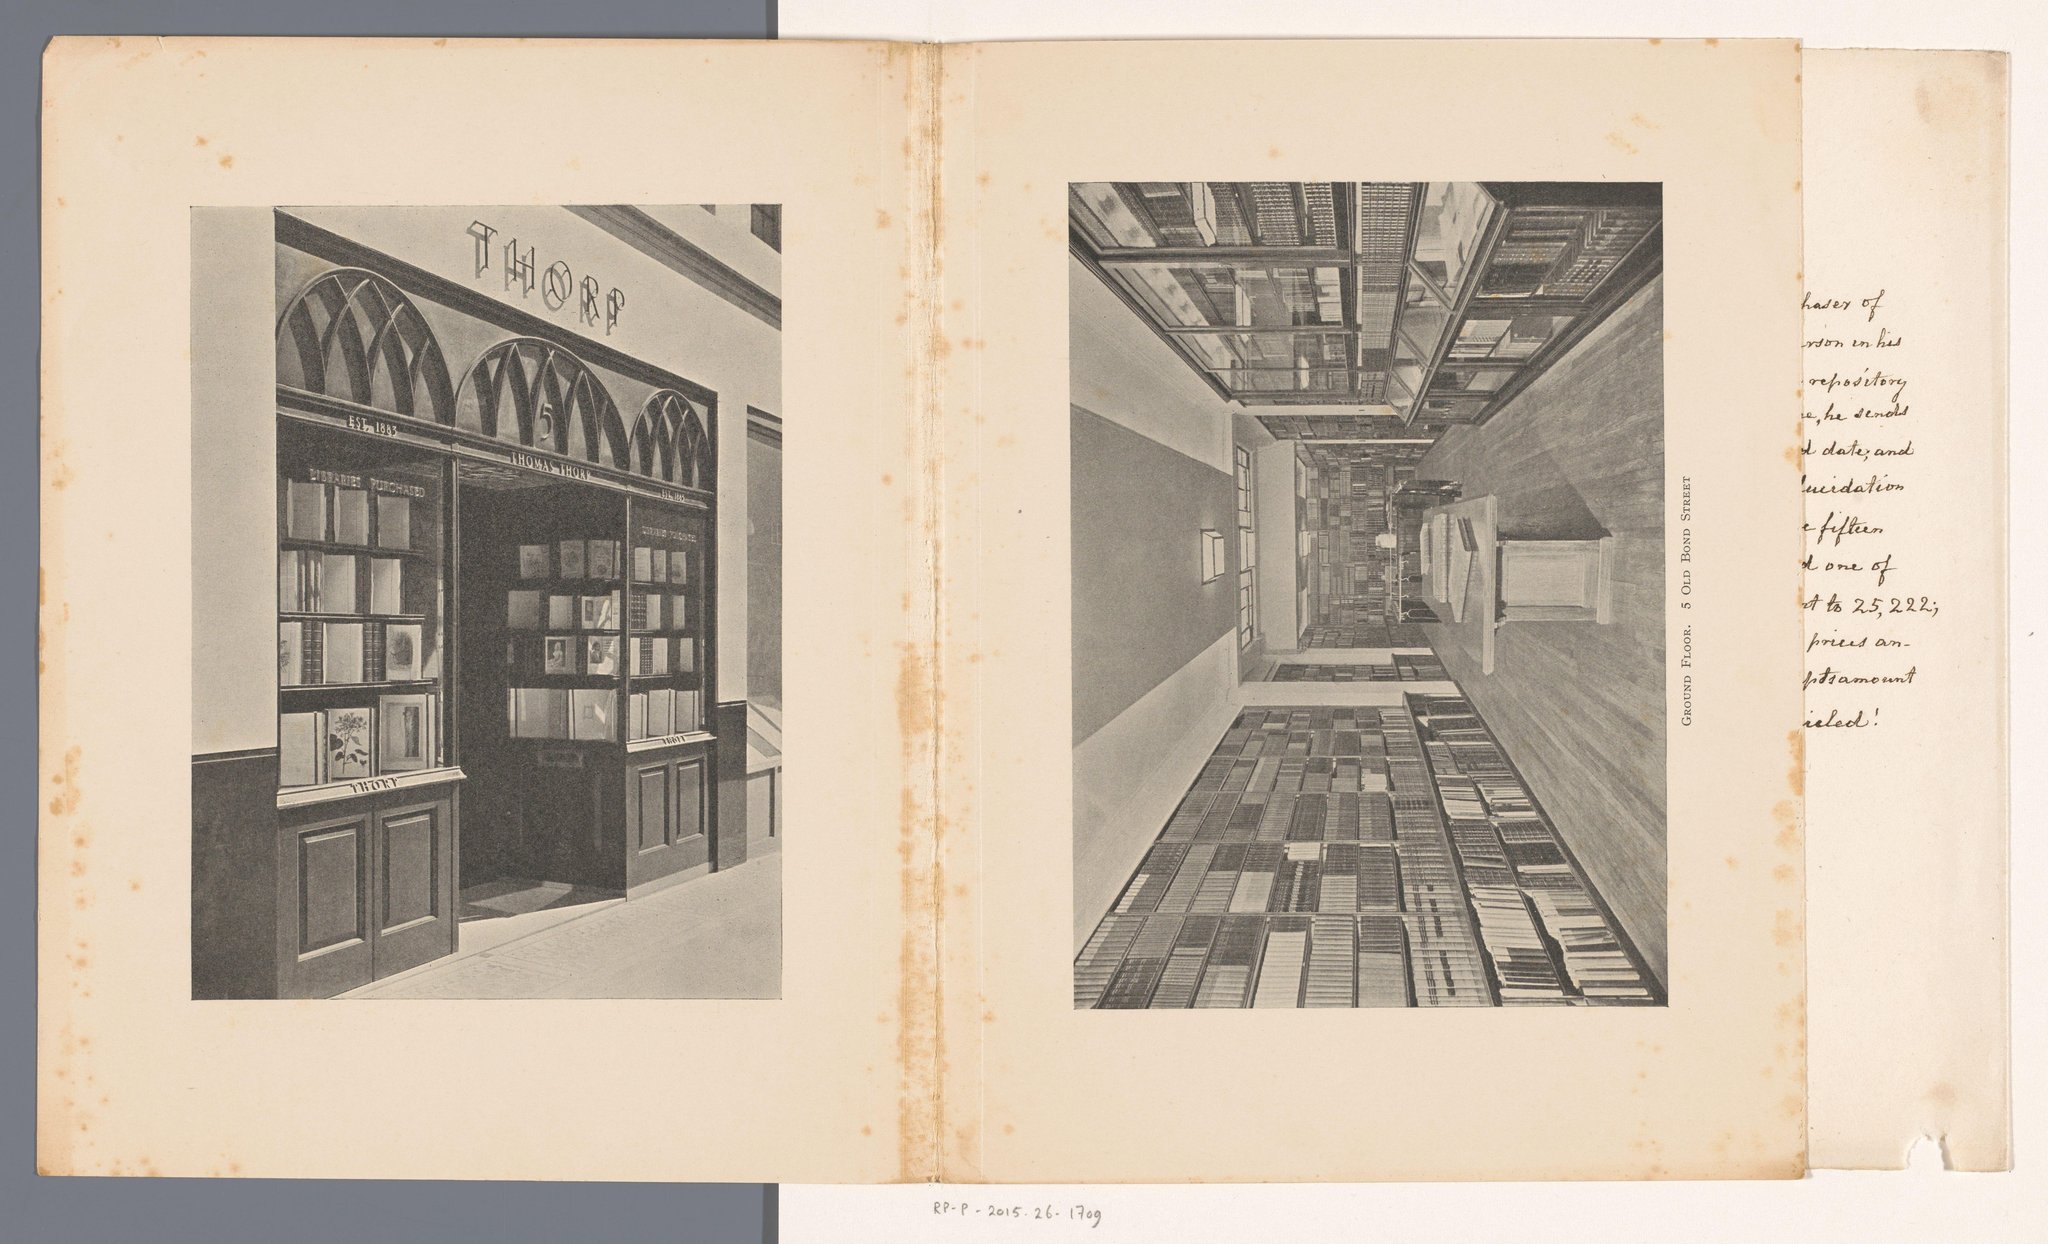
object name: print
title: Boekhandel van Thomas Thorp te Londen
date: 1933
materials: paper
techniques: autotype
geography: london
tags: shop, store, book-shop, bookseller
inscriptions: date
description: De prenten zijn gebruikt op de binnenzijde van verkoopcatalogus no. 164 van Thomas Thorpe, uitgeven in 1933. Op de achterzijde van de catalogus is de kelder te zien.